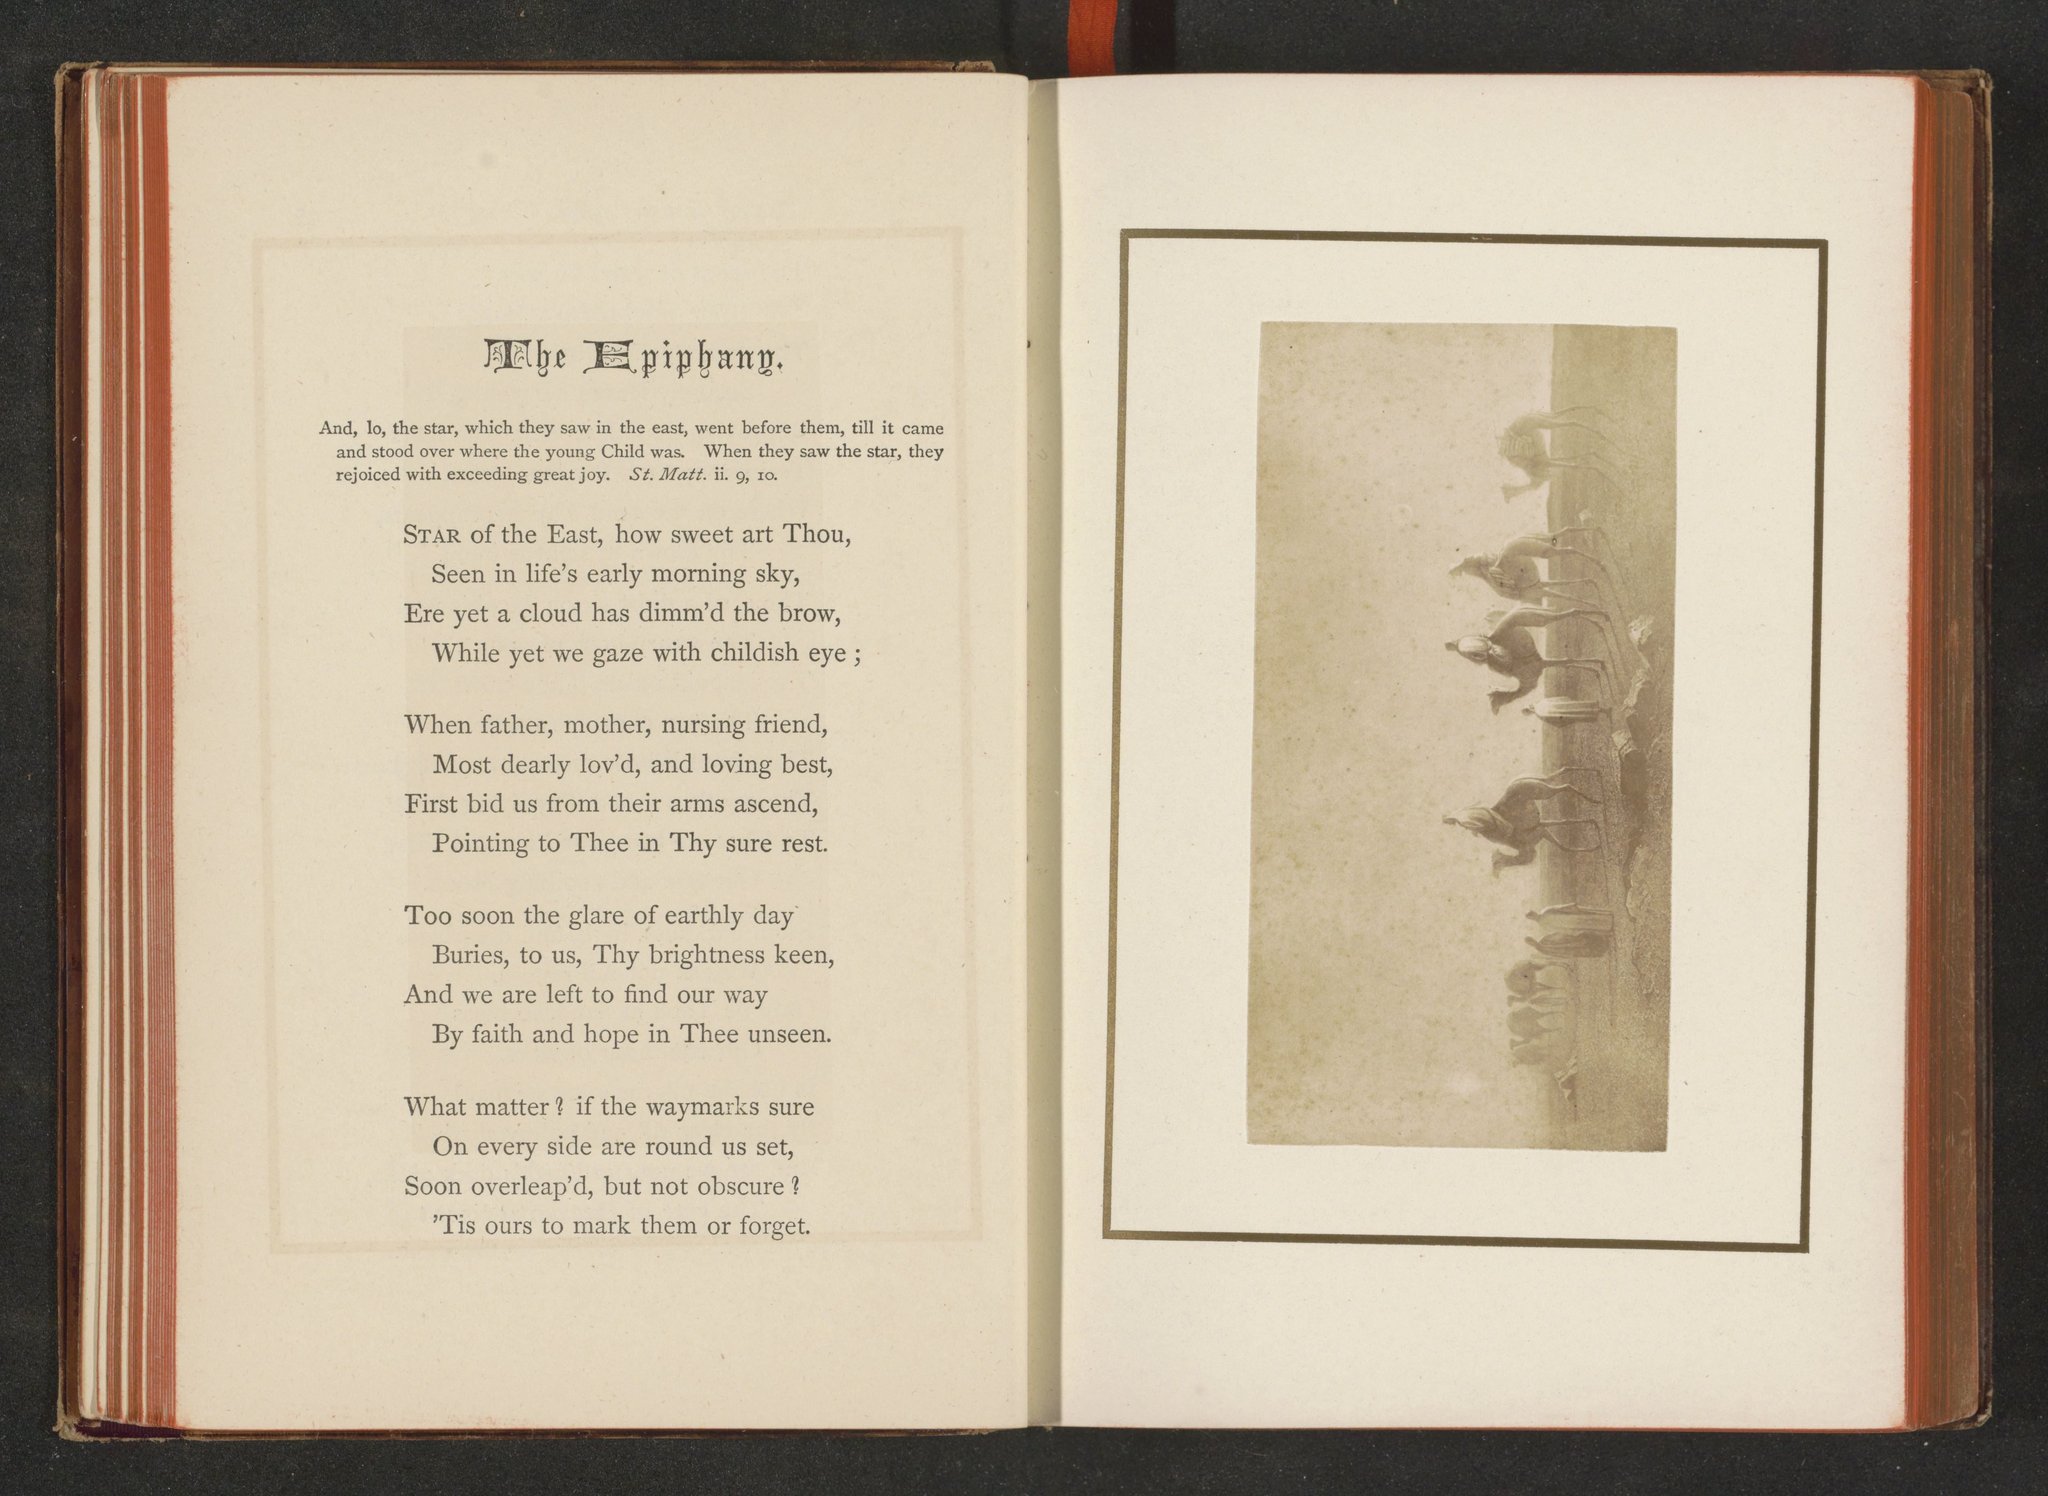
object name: photograph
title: Fotoreproductie van een schilderij, voorstellende de drie koningen op dromedarissen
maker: Anonymous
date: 1870-1875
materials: photographic support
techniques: albumen print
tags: hoofed animals: dromedary, journey of the three wise men to jerusalem